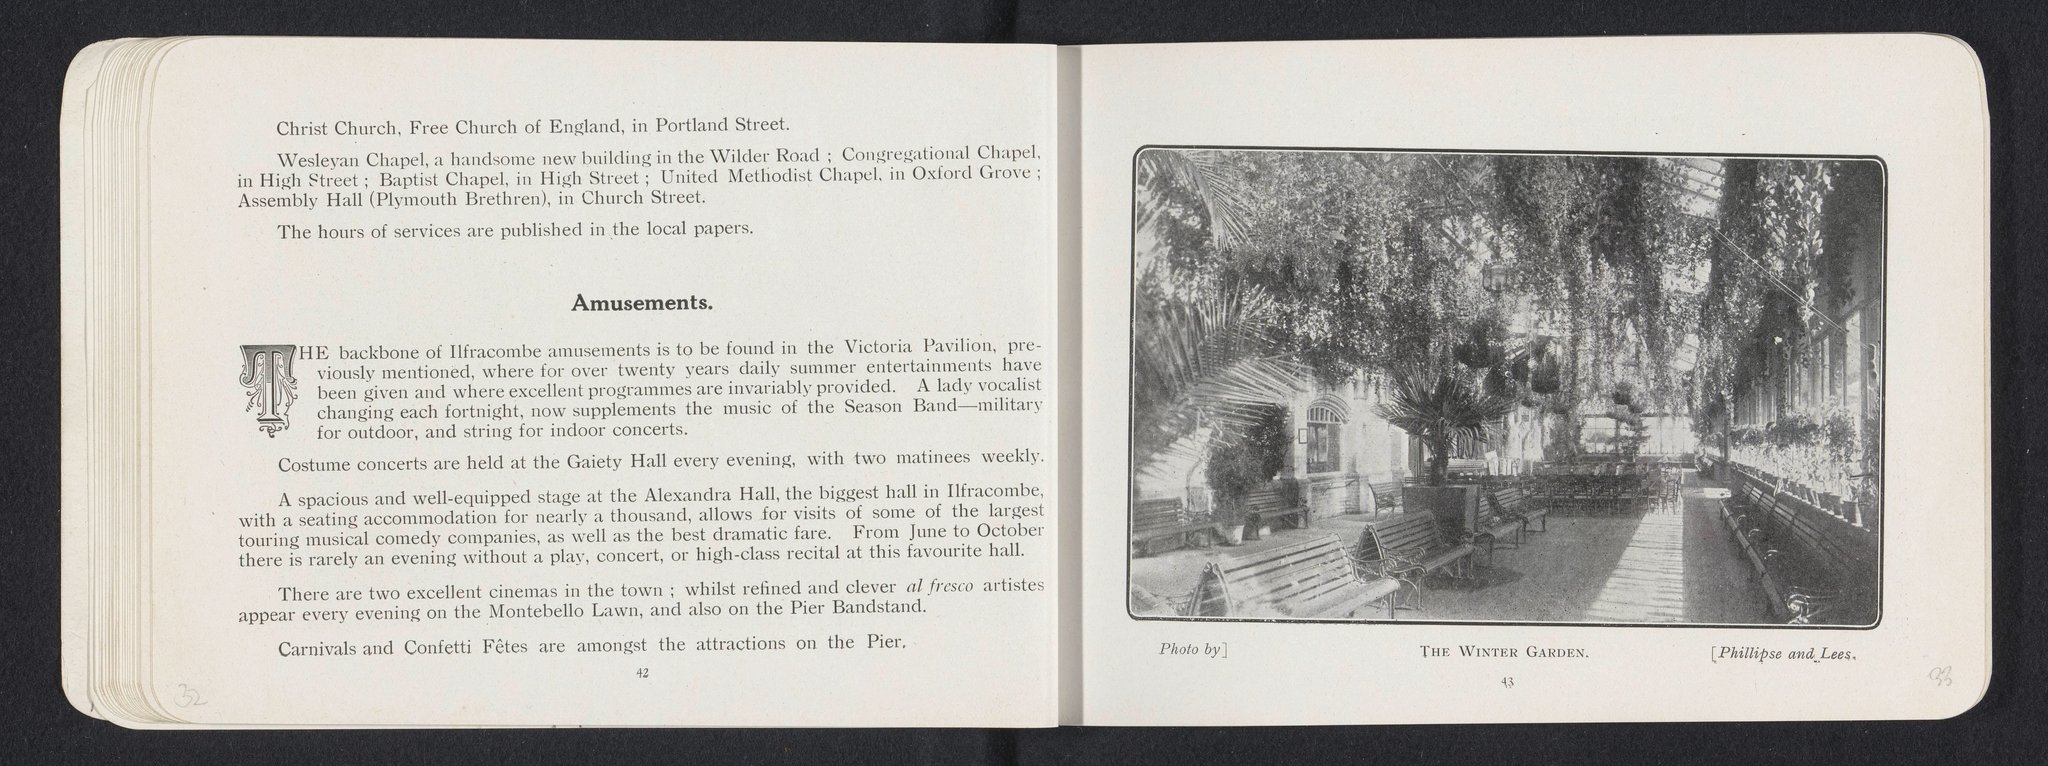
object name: page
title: The winter garden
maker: Anonymous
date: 1900-1920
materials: paper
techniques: autotype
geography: ilfracombe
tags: winter-garden, conservatory